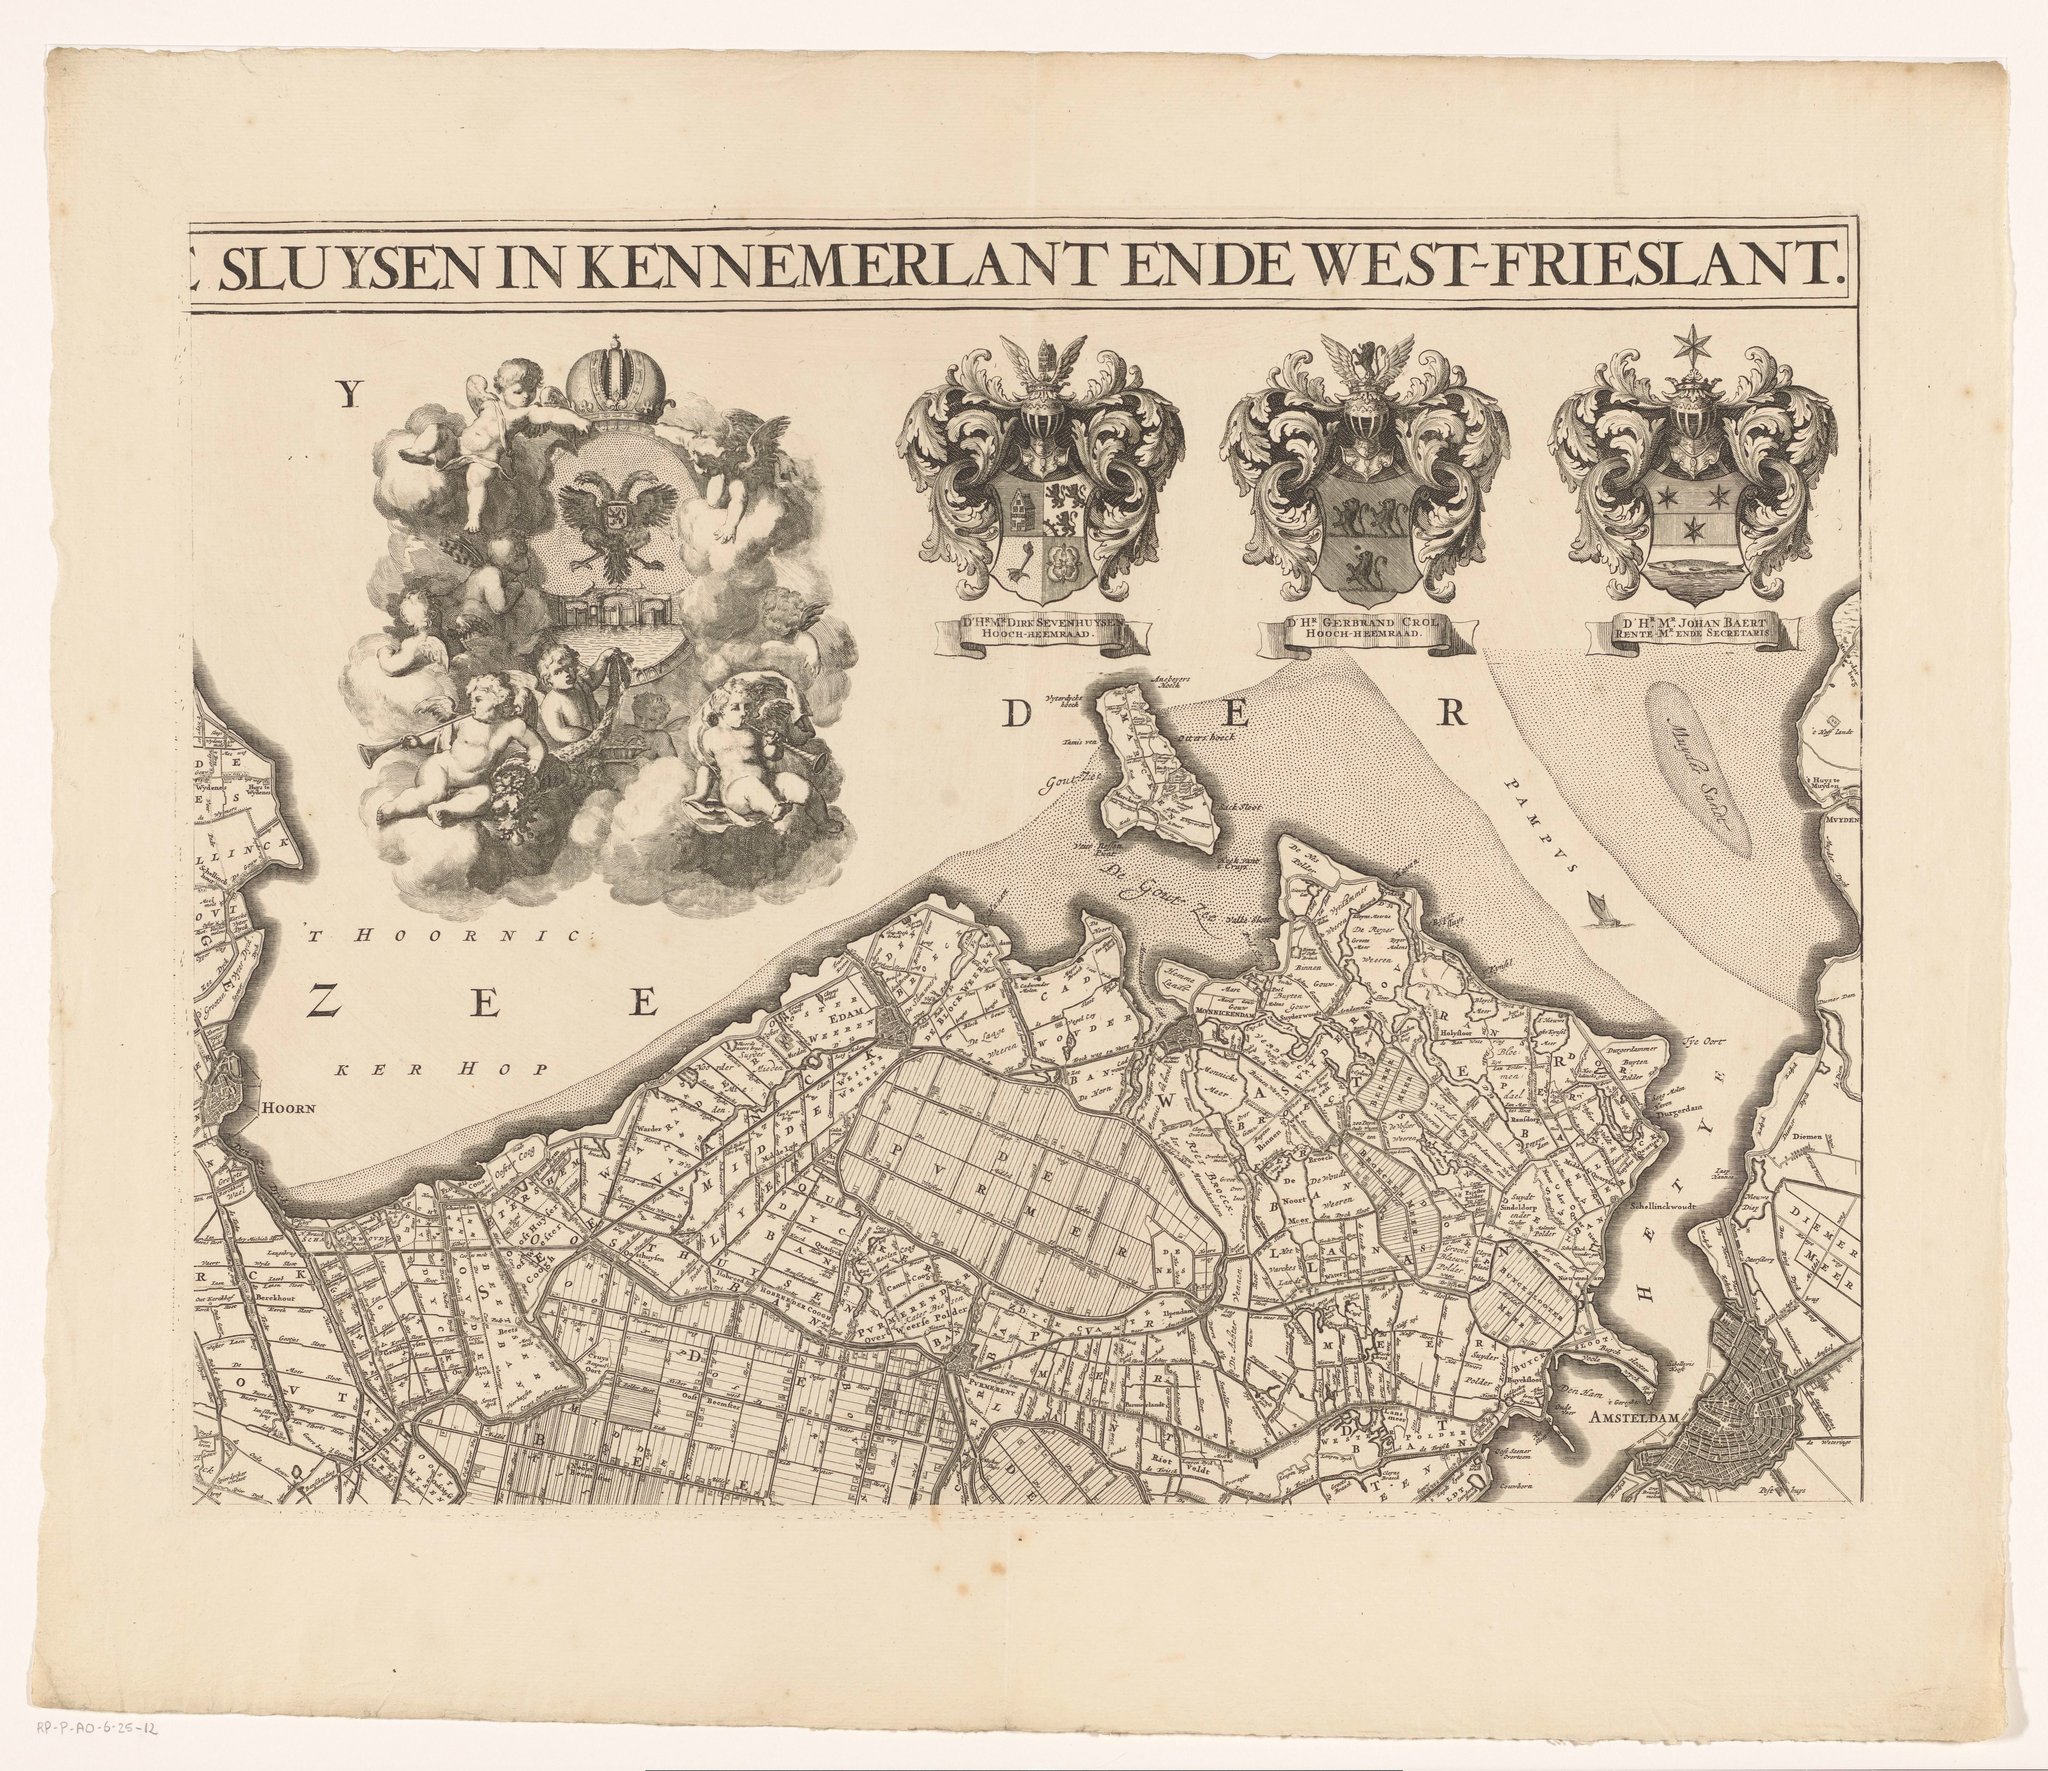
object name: map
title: 't Hoogh-heemraetschap vande Uytwaterende Sluysen in Kennemerlant ende West-Frieslant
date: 1745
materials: paper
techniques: engraving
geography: amsterdam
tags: coat of arms (as symbol of the state, etc.), maps of separate countries or regions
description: Deel (rechtsboven) van een kaart van Kennemerland en West-Friesland.